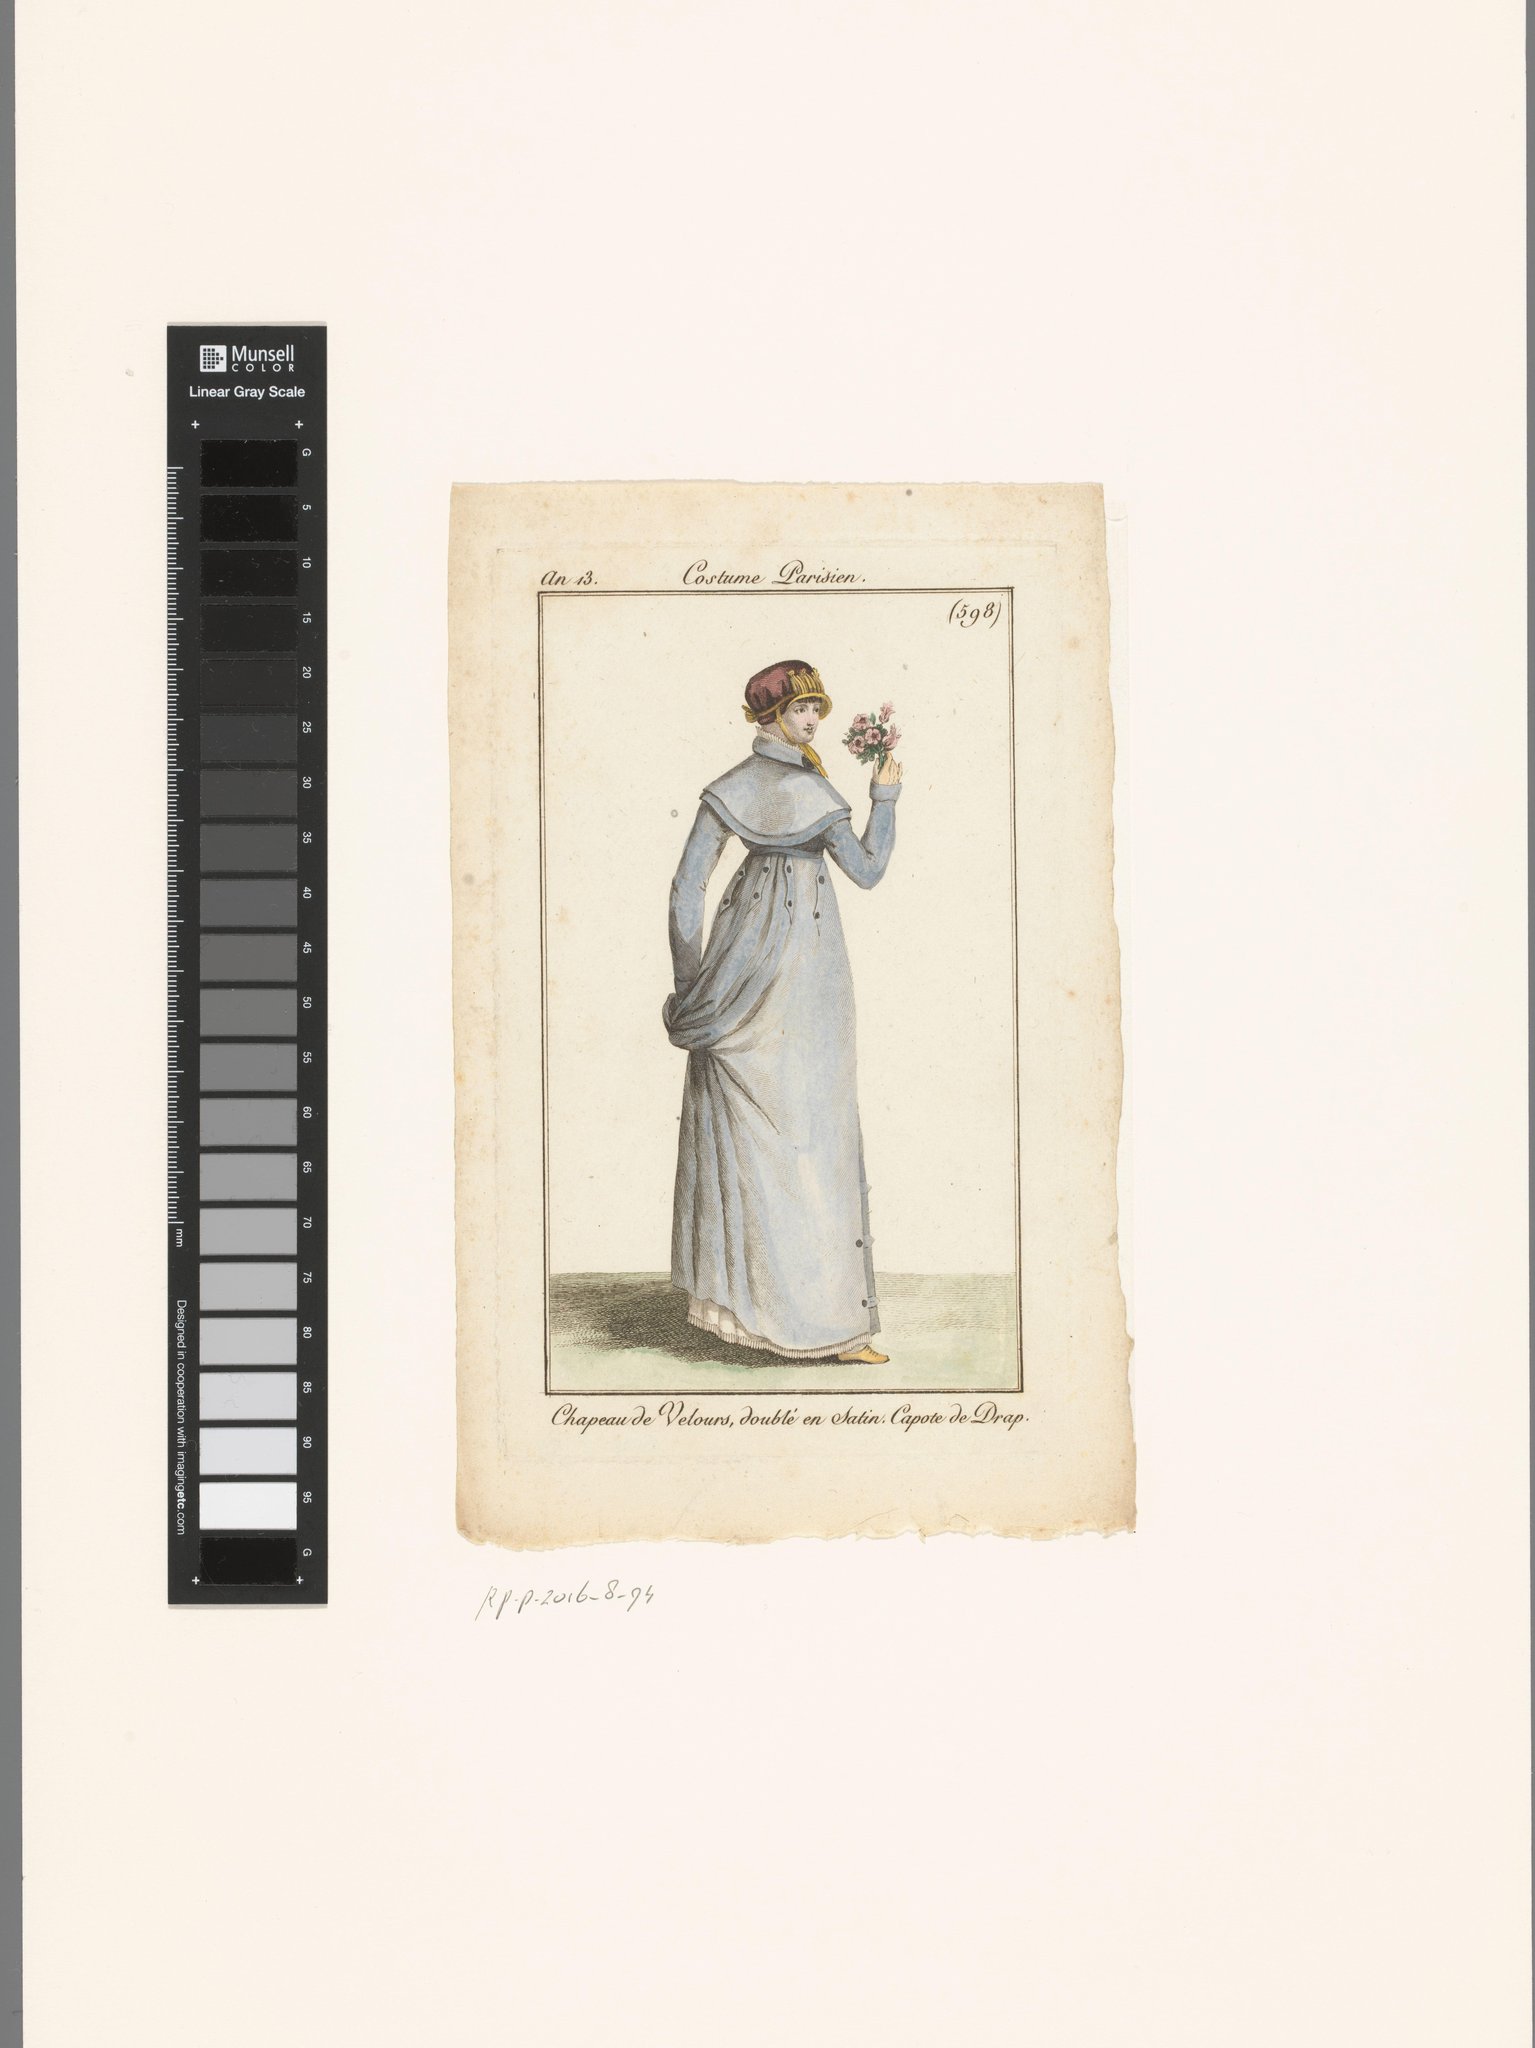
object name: fashion print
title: Journal des Dames et des modes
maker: Anonymous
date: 1804-1805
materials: paper, ink, watercolor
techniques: etching, hand coloring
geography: europe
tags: fashion plates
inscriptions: collector's mark: Lugt 2228